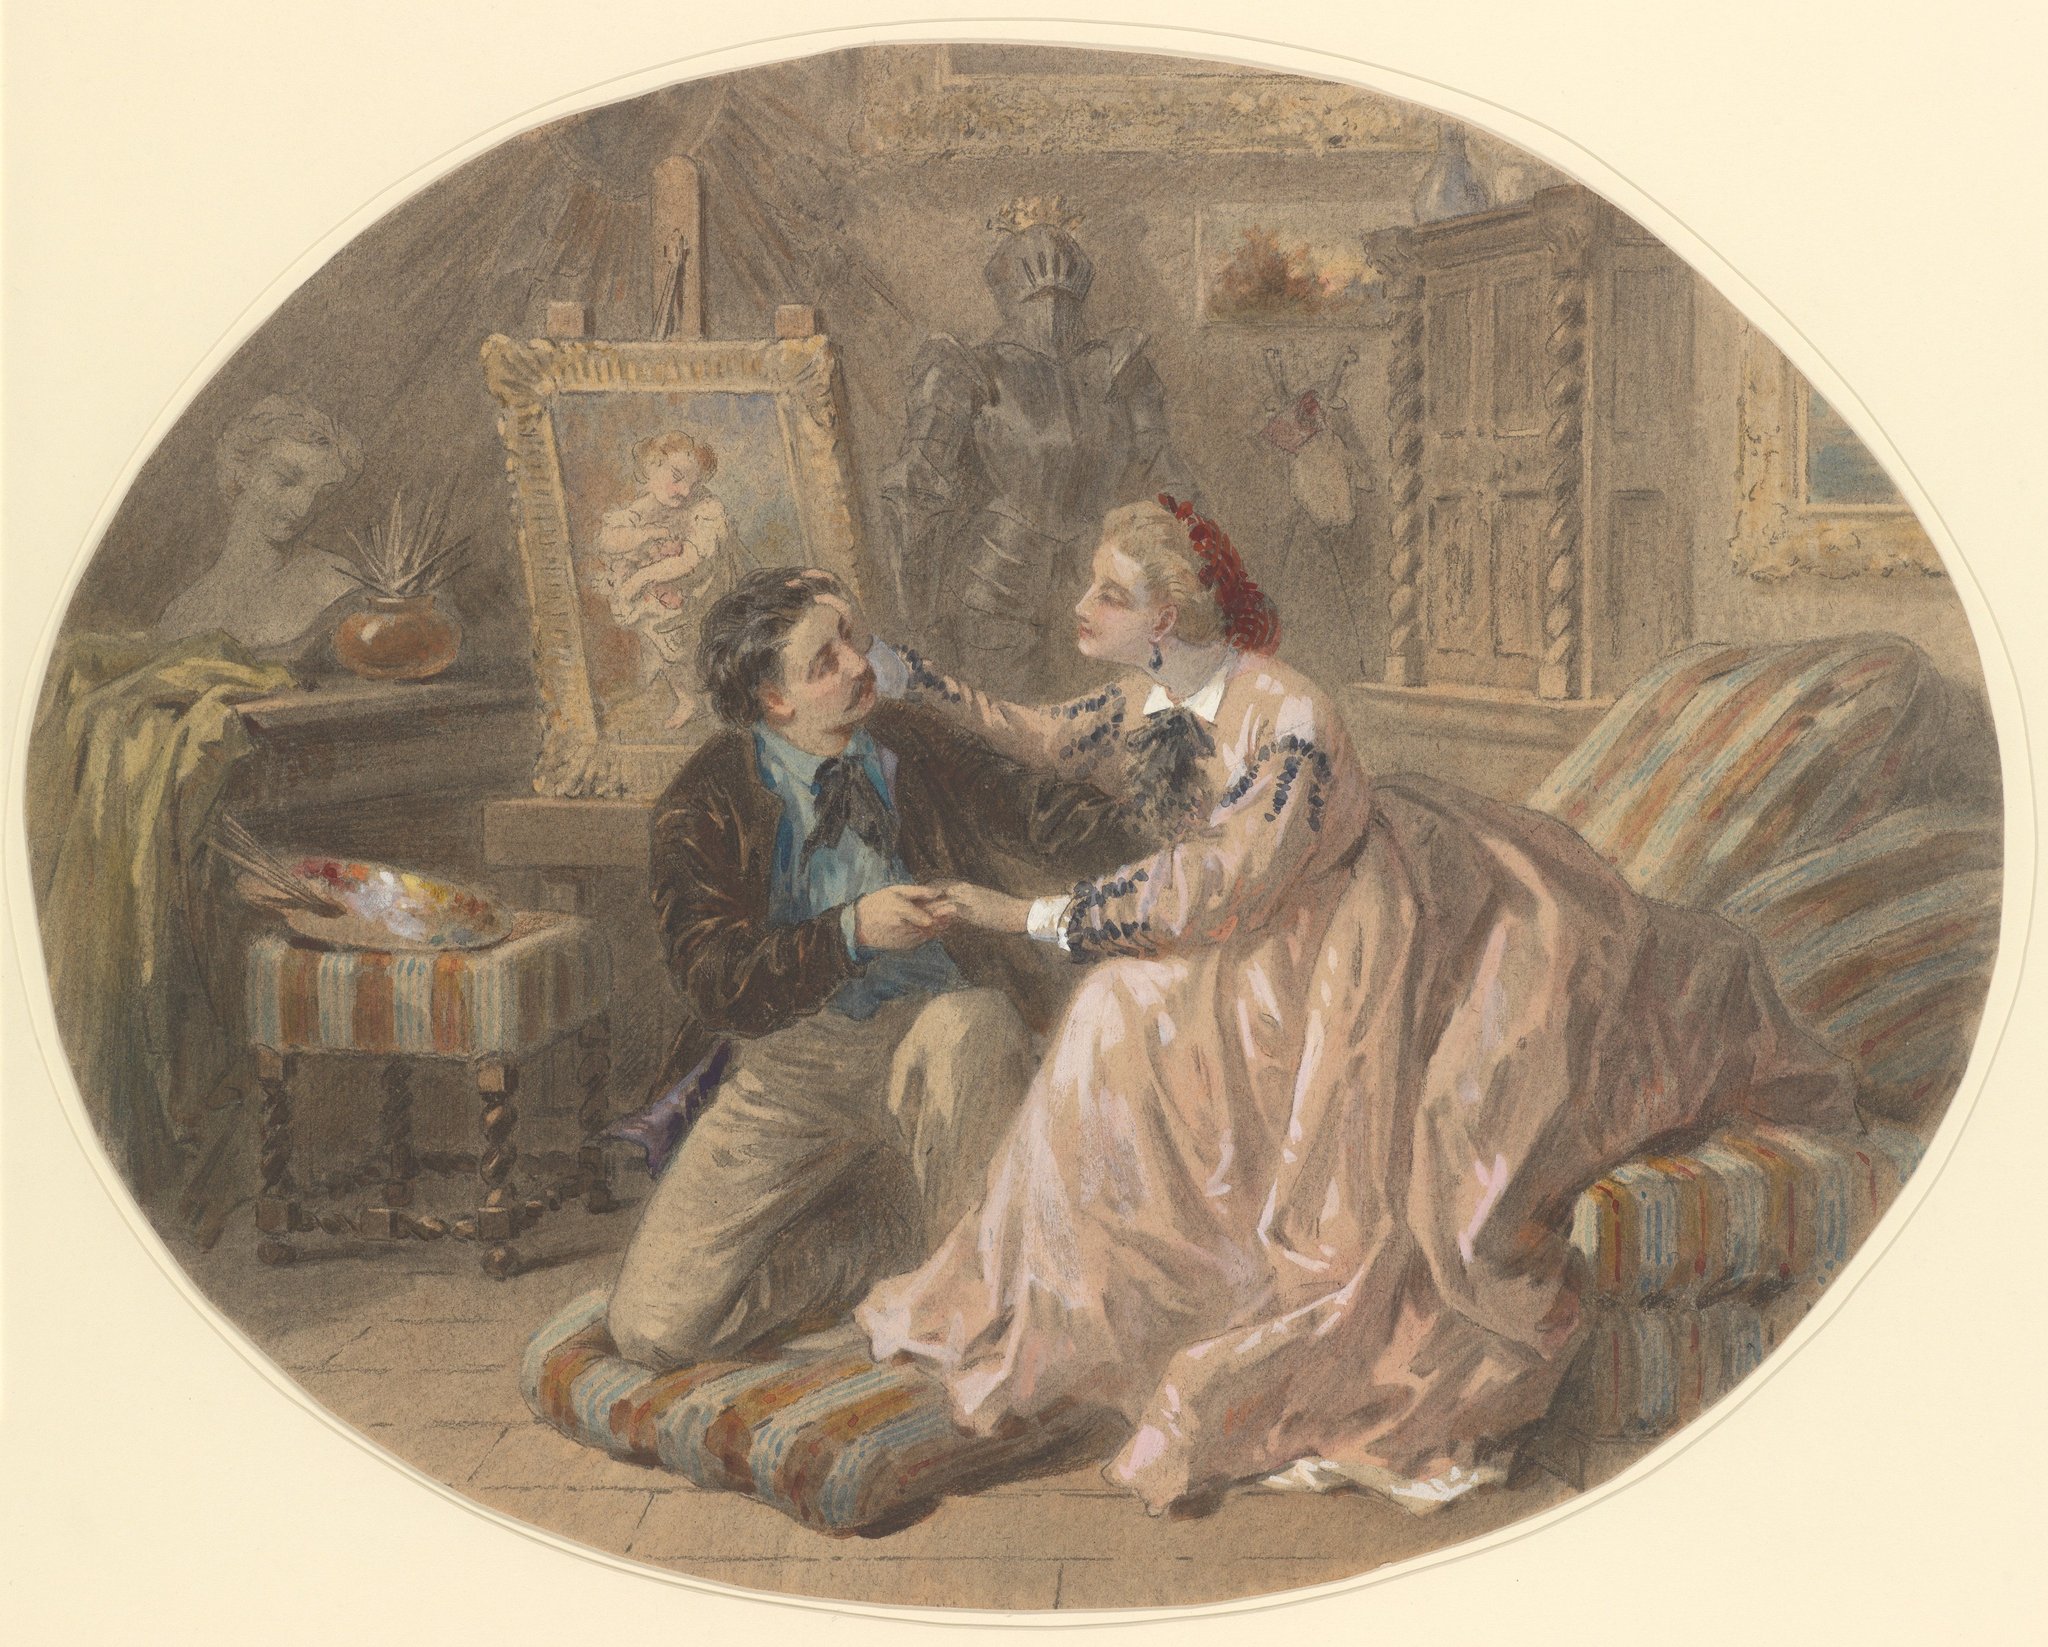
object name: drawing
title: Un Mari qu'on Aime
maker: paul-emile-anthony morlon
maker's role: artist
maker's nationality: french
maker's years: 1845-1905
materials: chalk, gouache, watercolor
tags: love,couples,men,women,artists